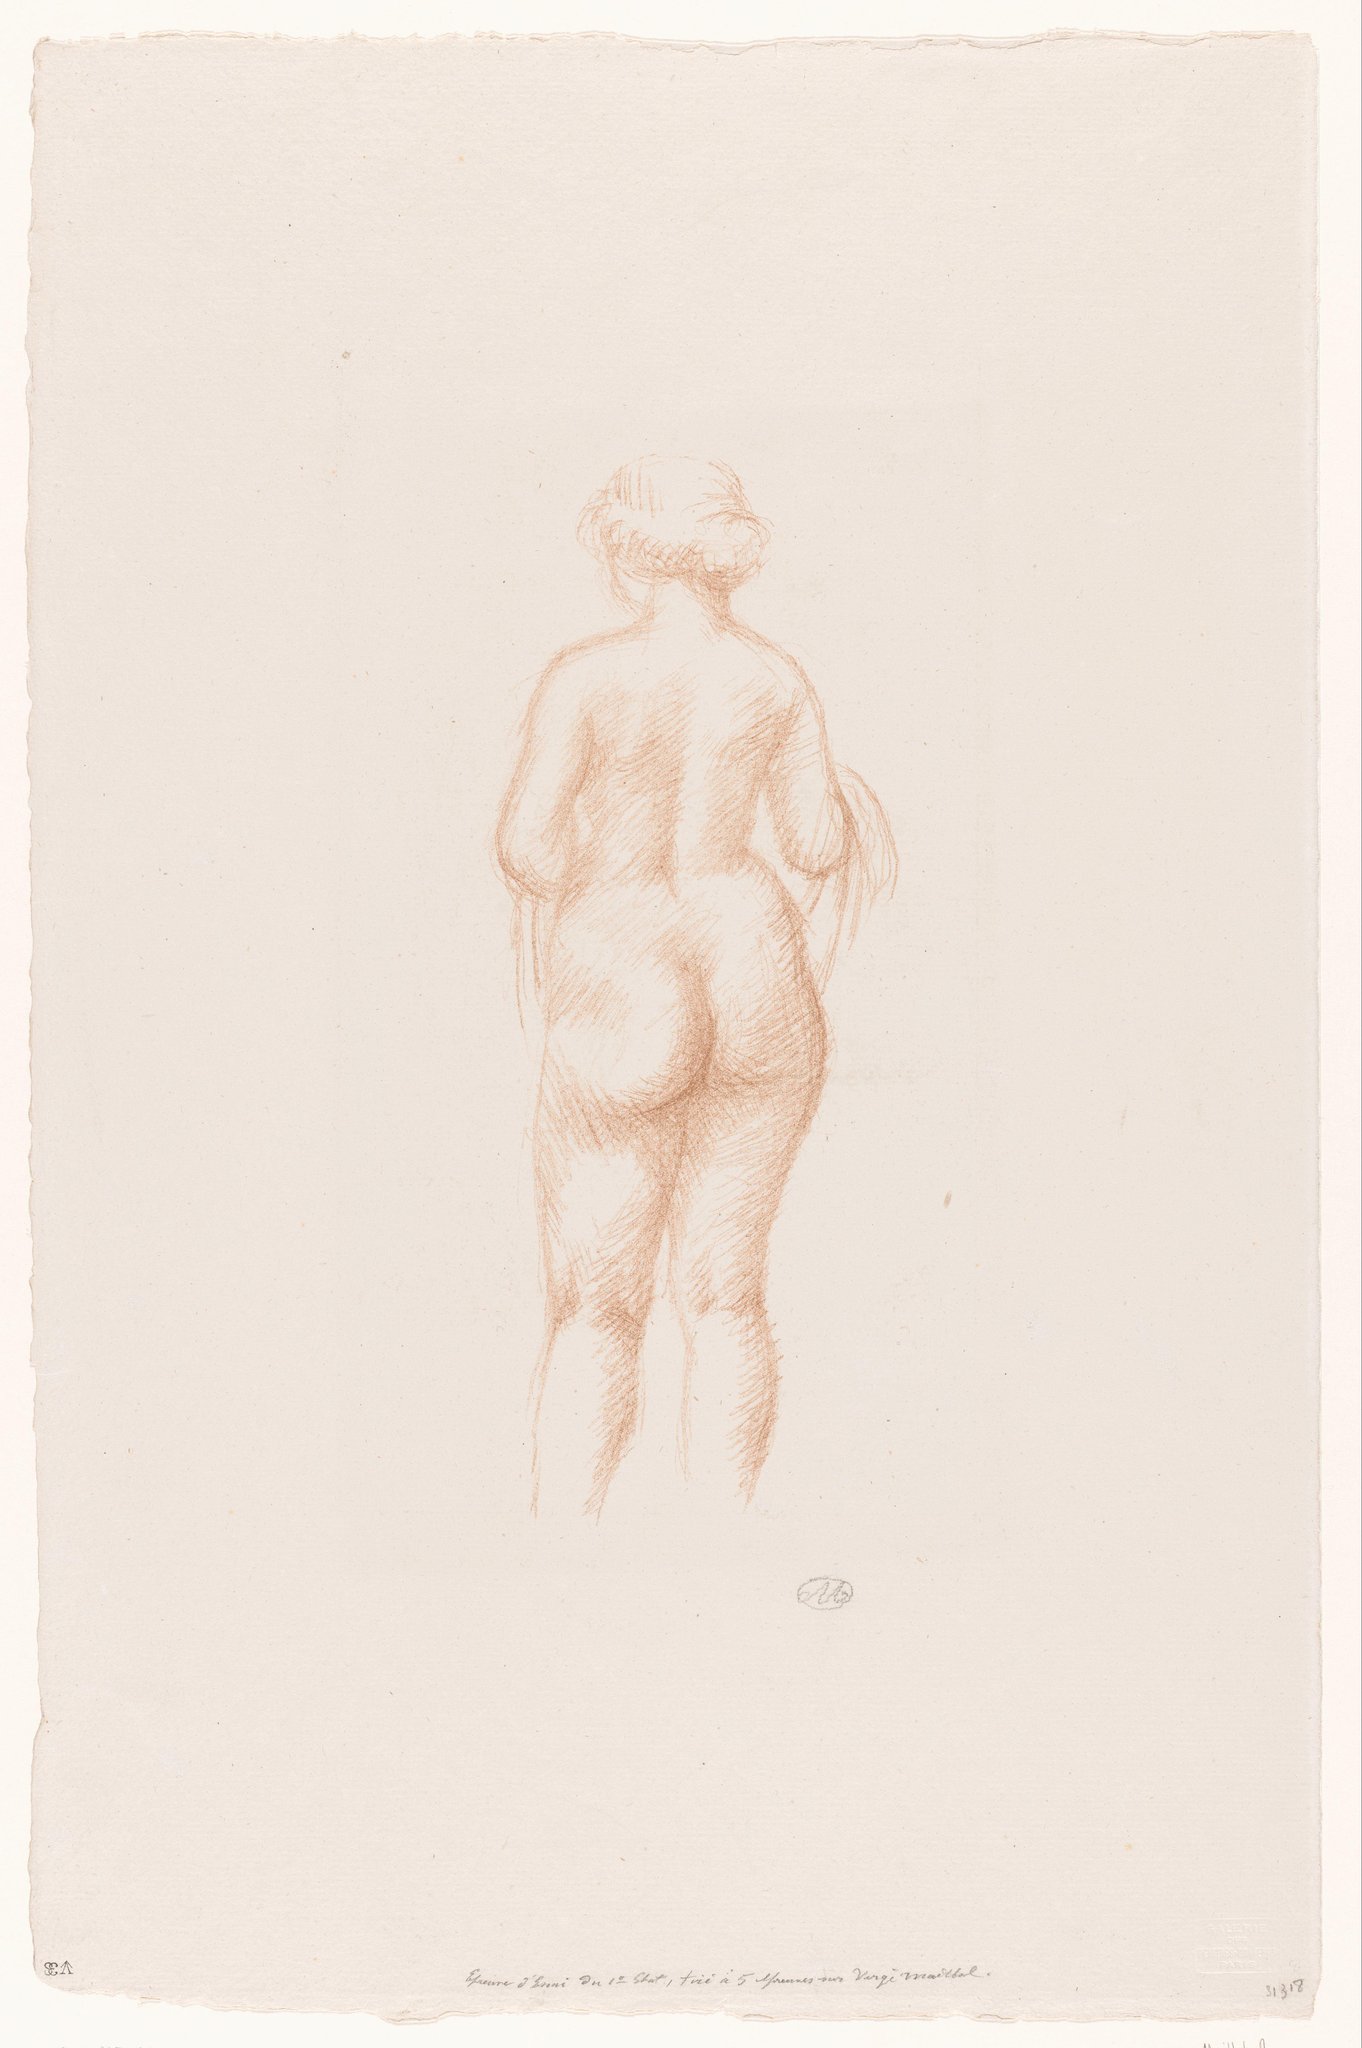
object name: print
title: Naakte vrouw met sjaal in haar armen op de rug gezien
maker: aristide maillol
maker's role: draughtsman, painter, print maker, sculptor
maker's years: 1861-1944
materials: paper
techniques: lithograph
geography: paris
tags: standing figure - aa - female human figure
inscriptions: stamp: Lugt 2921b, monogram: ‘M’, check stamp: ‘Galerie des Peintres-Graveurs Paris’ Lugt 1057b, inscription: ‘Epreuve d'essai du 1e état, tiré à 5 epreuves sur vergé Maillol’, stamp: Lugt 2921c, inscription: ‘31318’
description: Latere staten van prent ook verschenen in: Album Les Peintres Lithographes de Manet à Matisse. Parijs: Frapier, 1924.